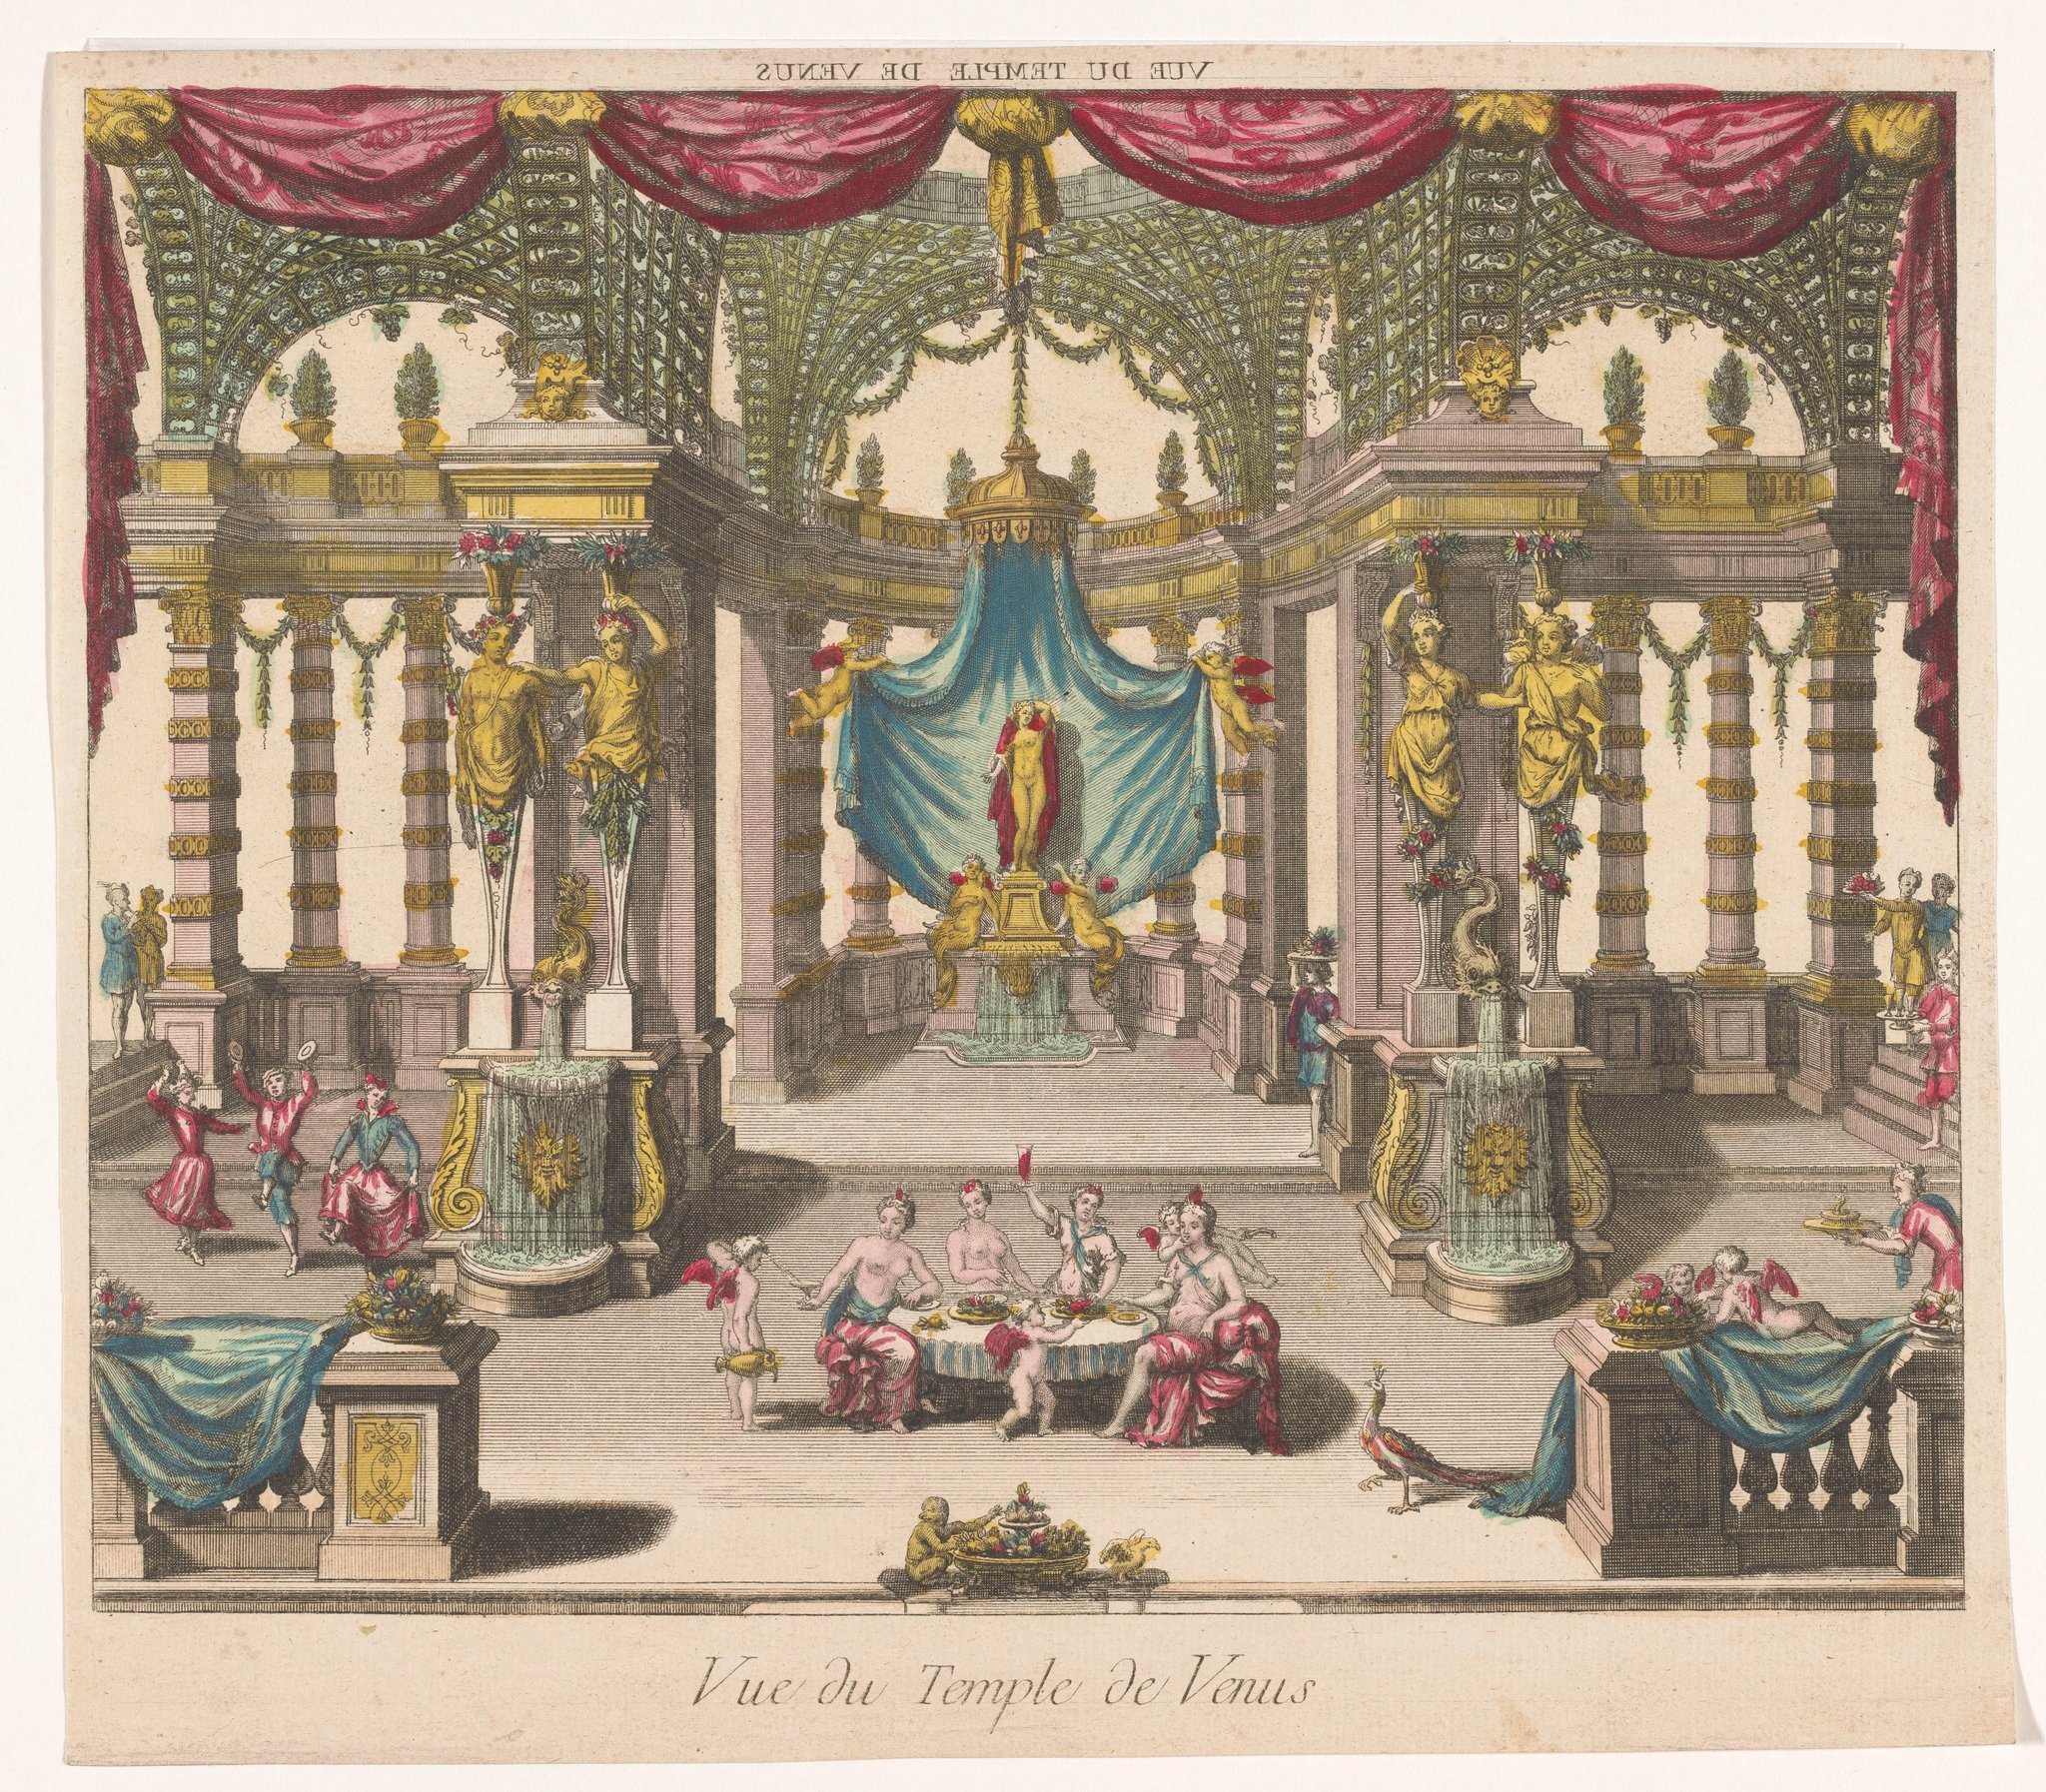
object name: opticaprent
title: Gezicht op het interieur van de Tempel van Venus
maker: Anonymous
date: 1700-1799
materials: paper, watercolor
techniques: brush, etching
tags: (story of) venus (aphrodite), temple, shrine ~ roman religion, interior ~ representation of a building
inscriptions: watermark, collector's mark: Lugt 2233